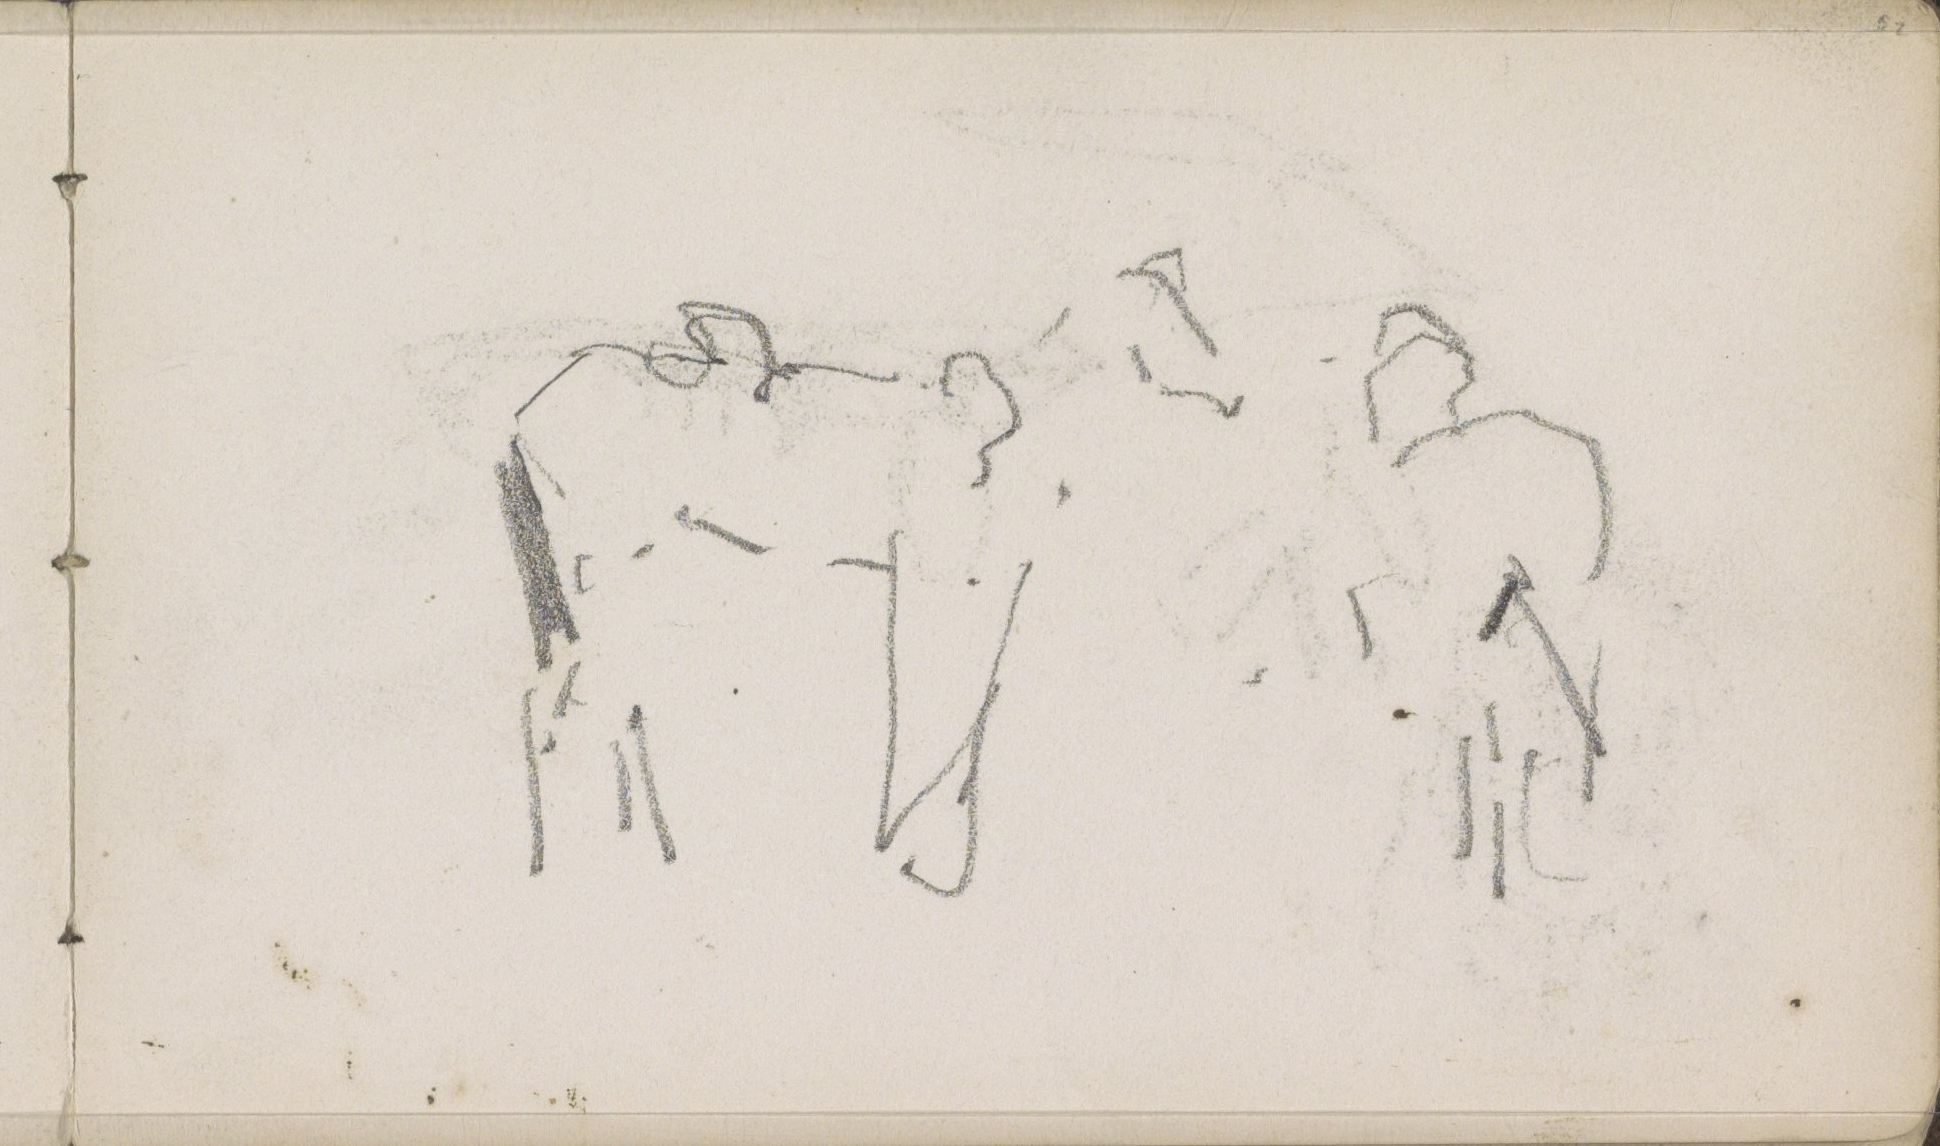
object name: sketchbook leaf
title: Twee paarden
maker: george hendrik breitner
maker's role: draughtsman, painter, print maker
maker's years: 1857-1923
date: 1881-1883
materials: paper, pencil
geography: north brabant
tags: horse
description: Pagina 52 uit een schetsboek met 42 bladen.